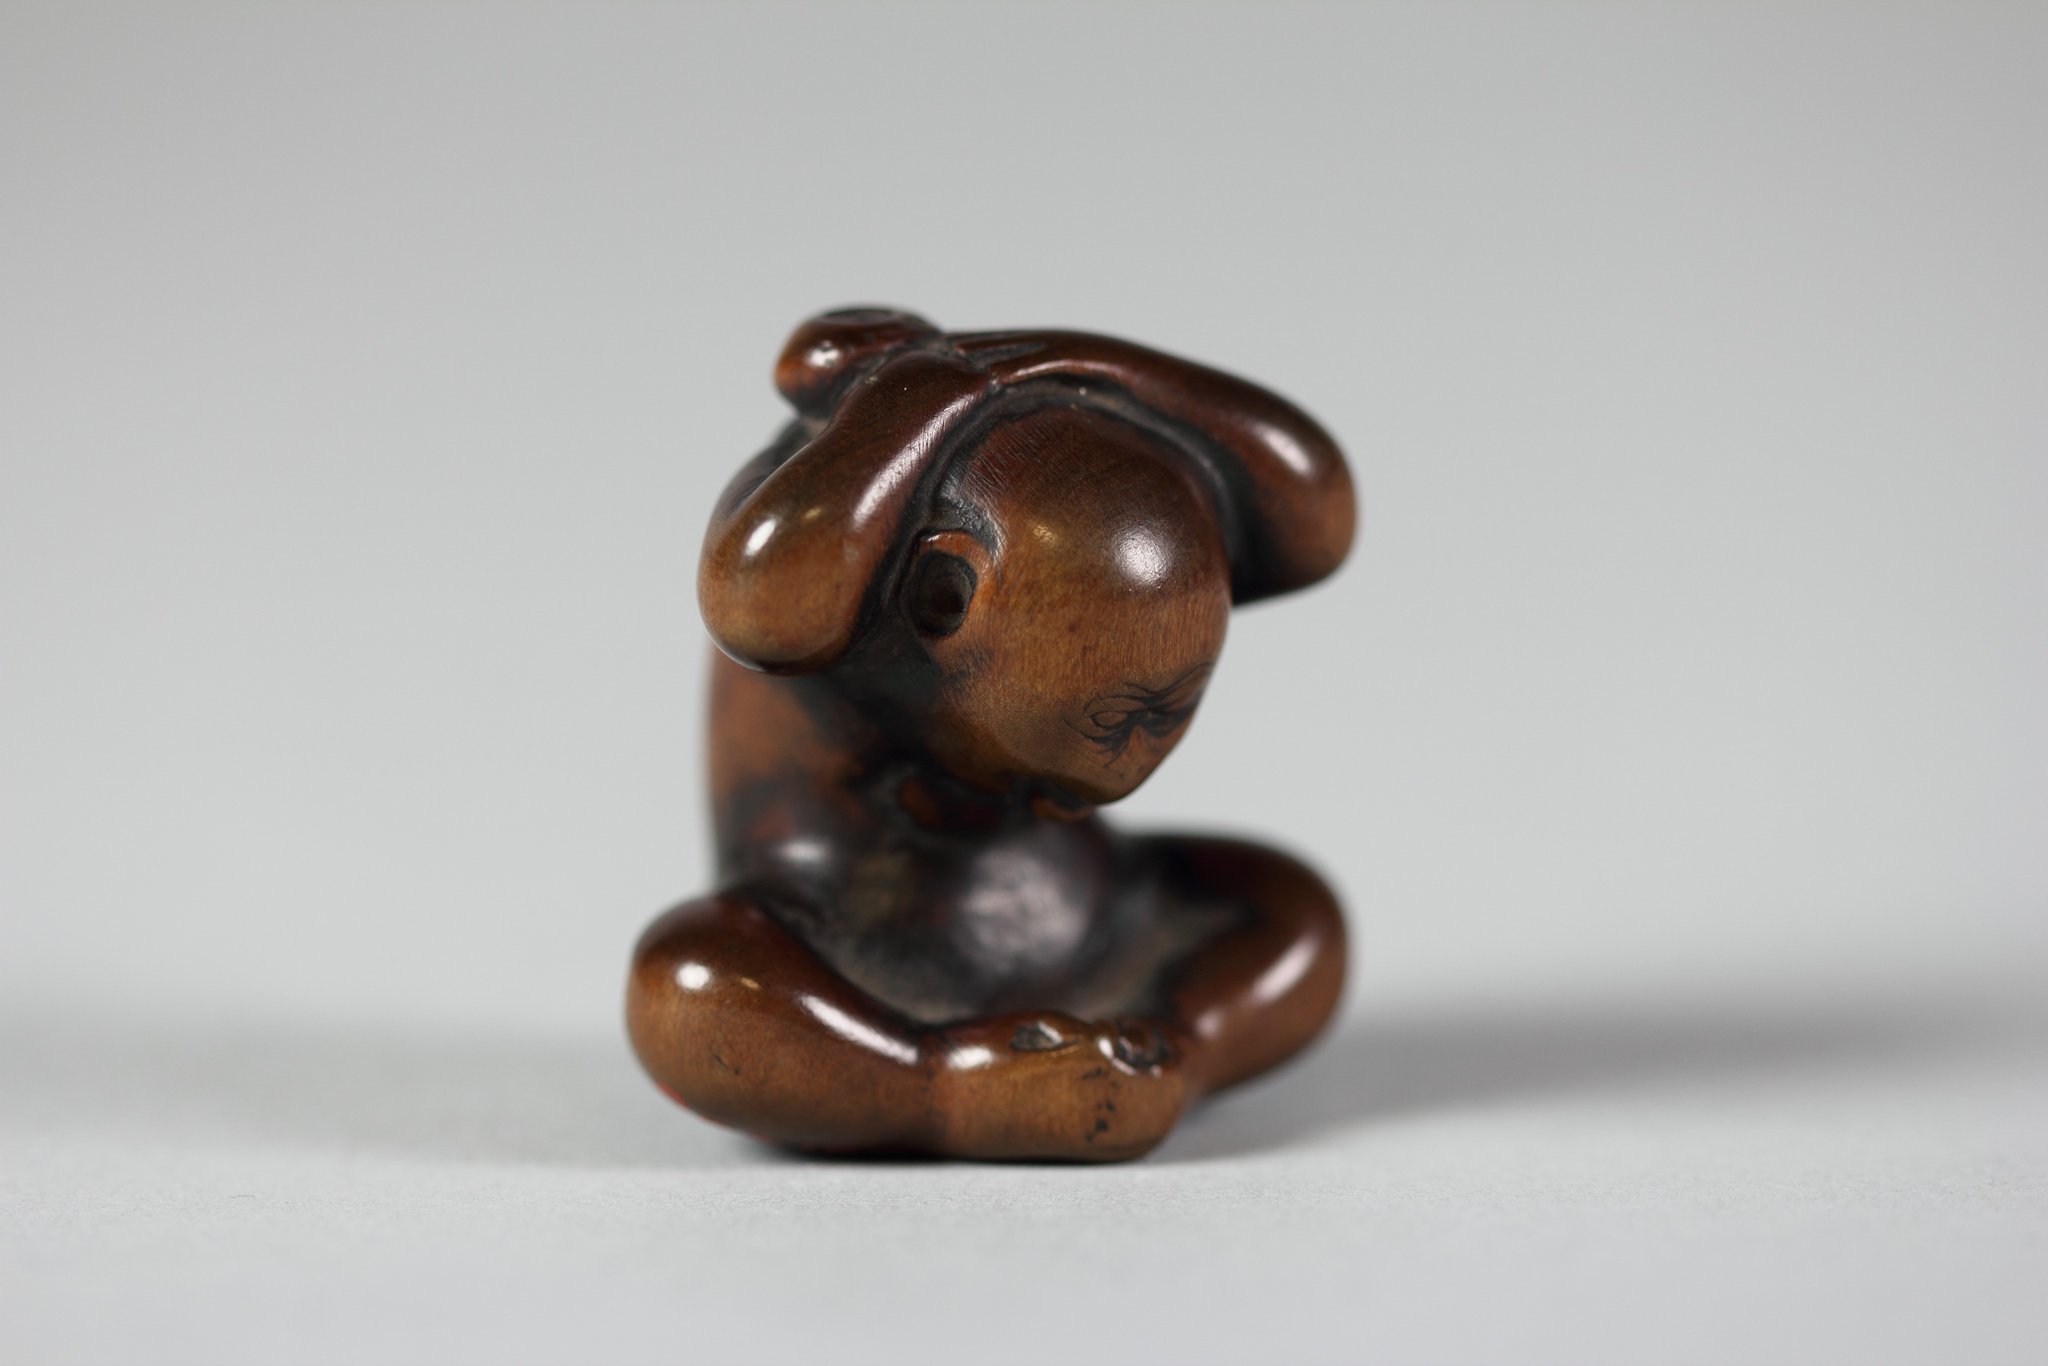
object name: netsuke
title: Netsuke of Monkey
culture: japanese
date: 1701-1800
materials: wood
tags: monkeys